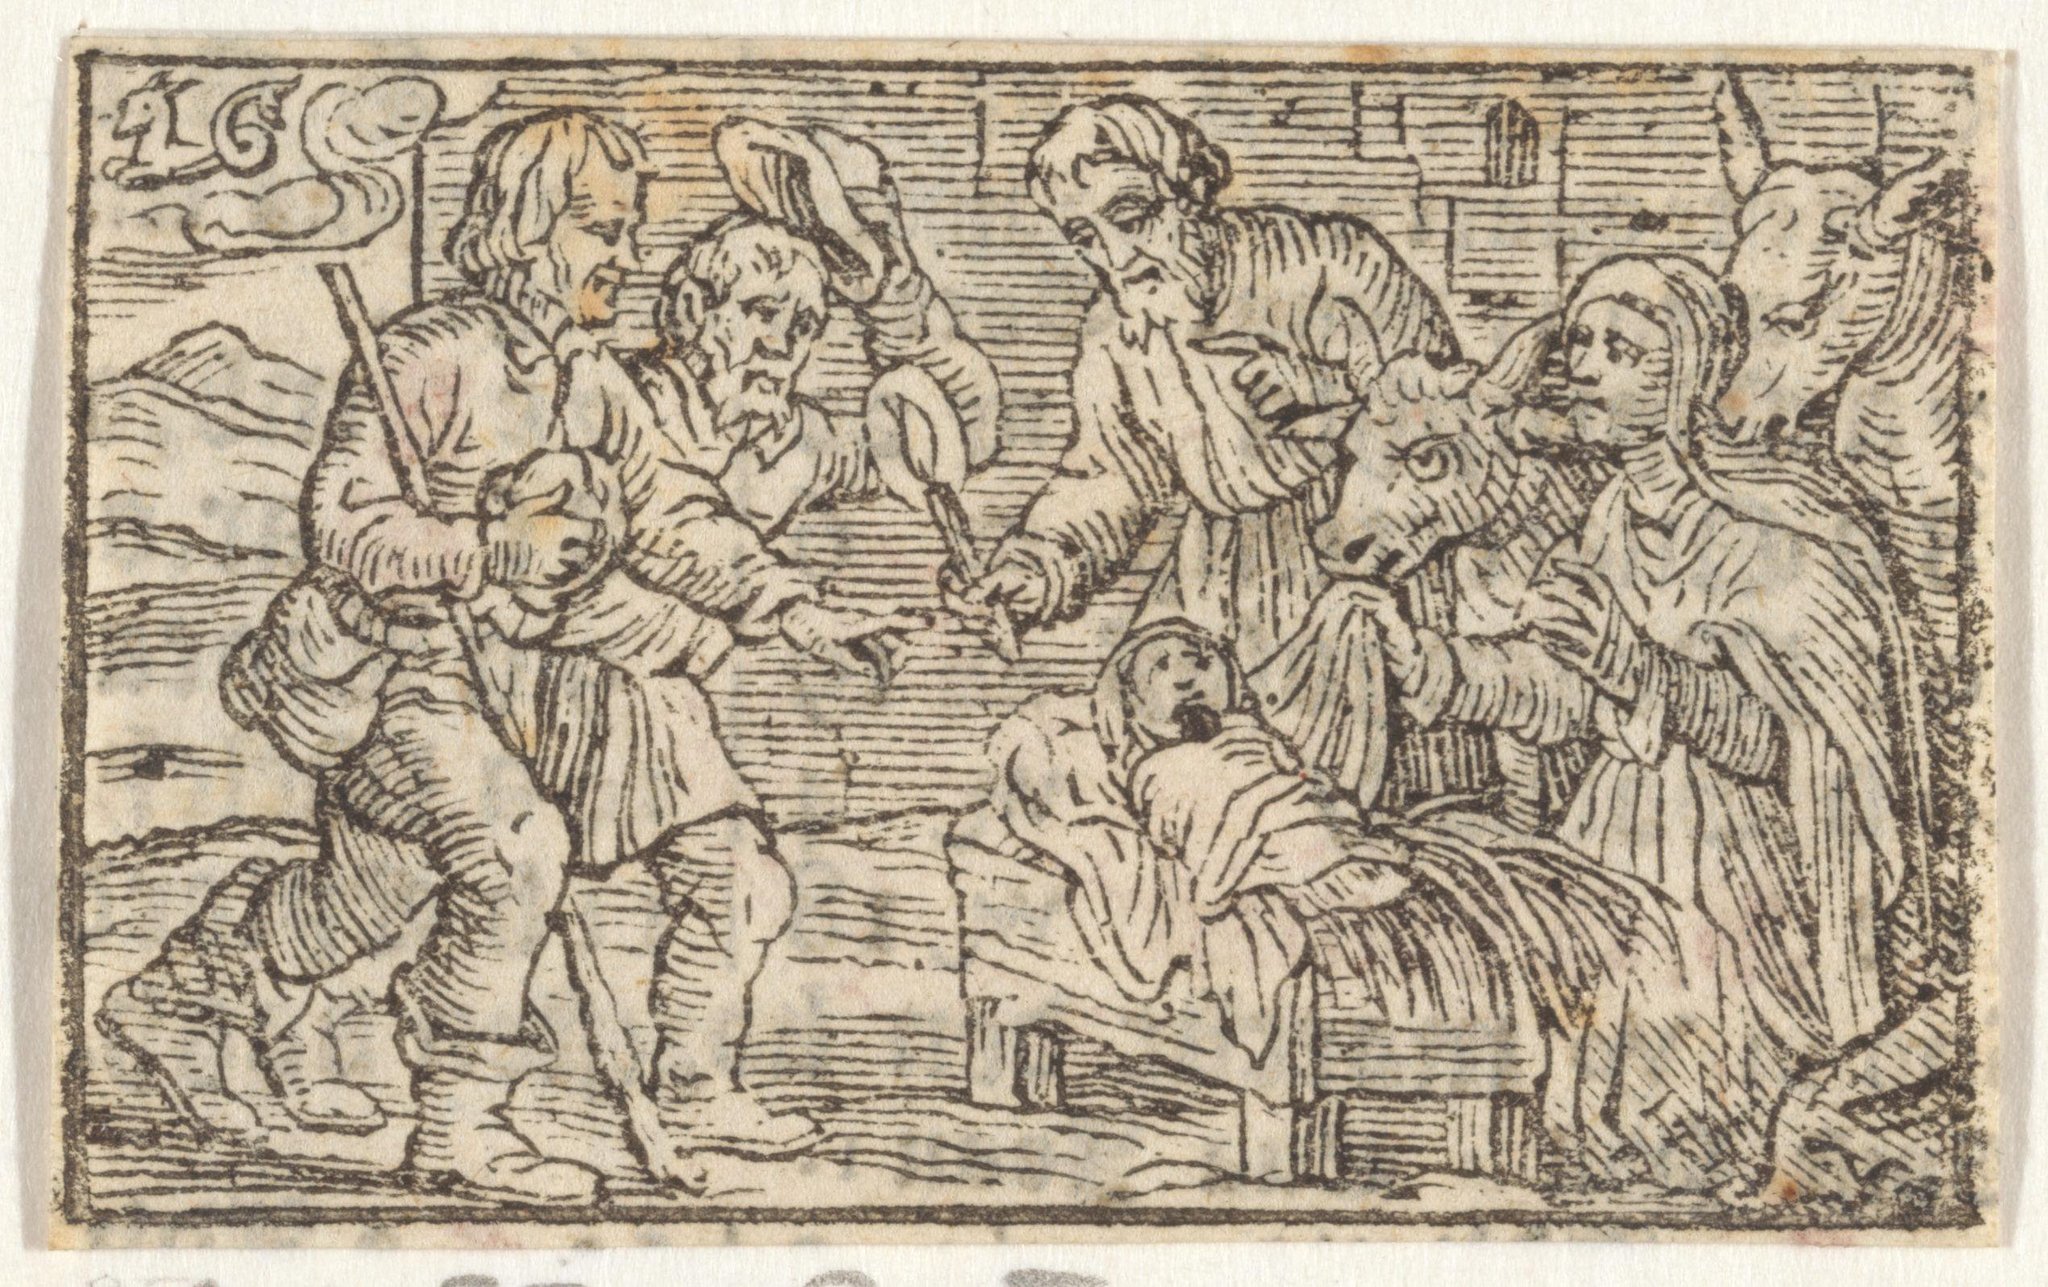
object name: book illustration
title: Maanden van het jaar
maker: Anonymous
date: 1600-1699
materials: paper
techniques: letterpress printing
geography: netherlands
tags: adoration of the christ-child by the shepherds; mary and joseph present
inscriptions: collector's mark: Lugt 240